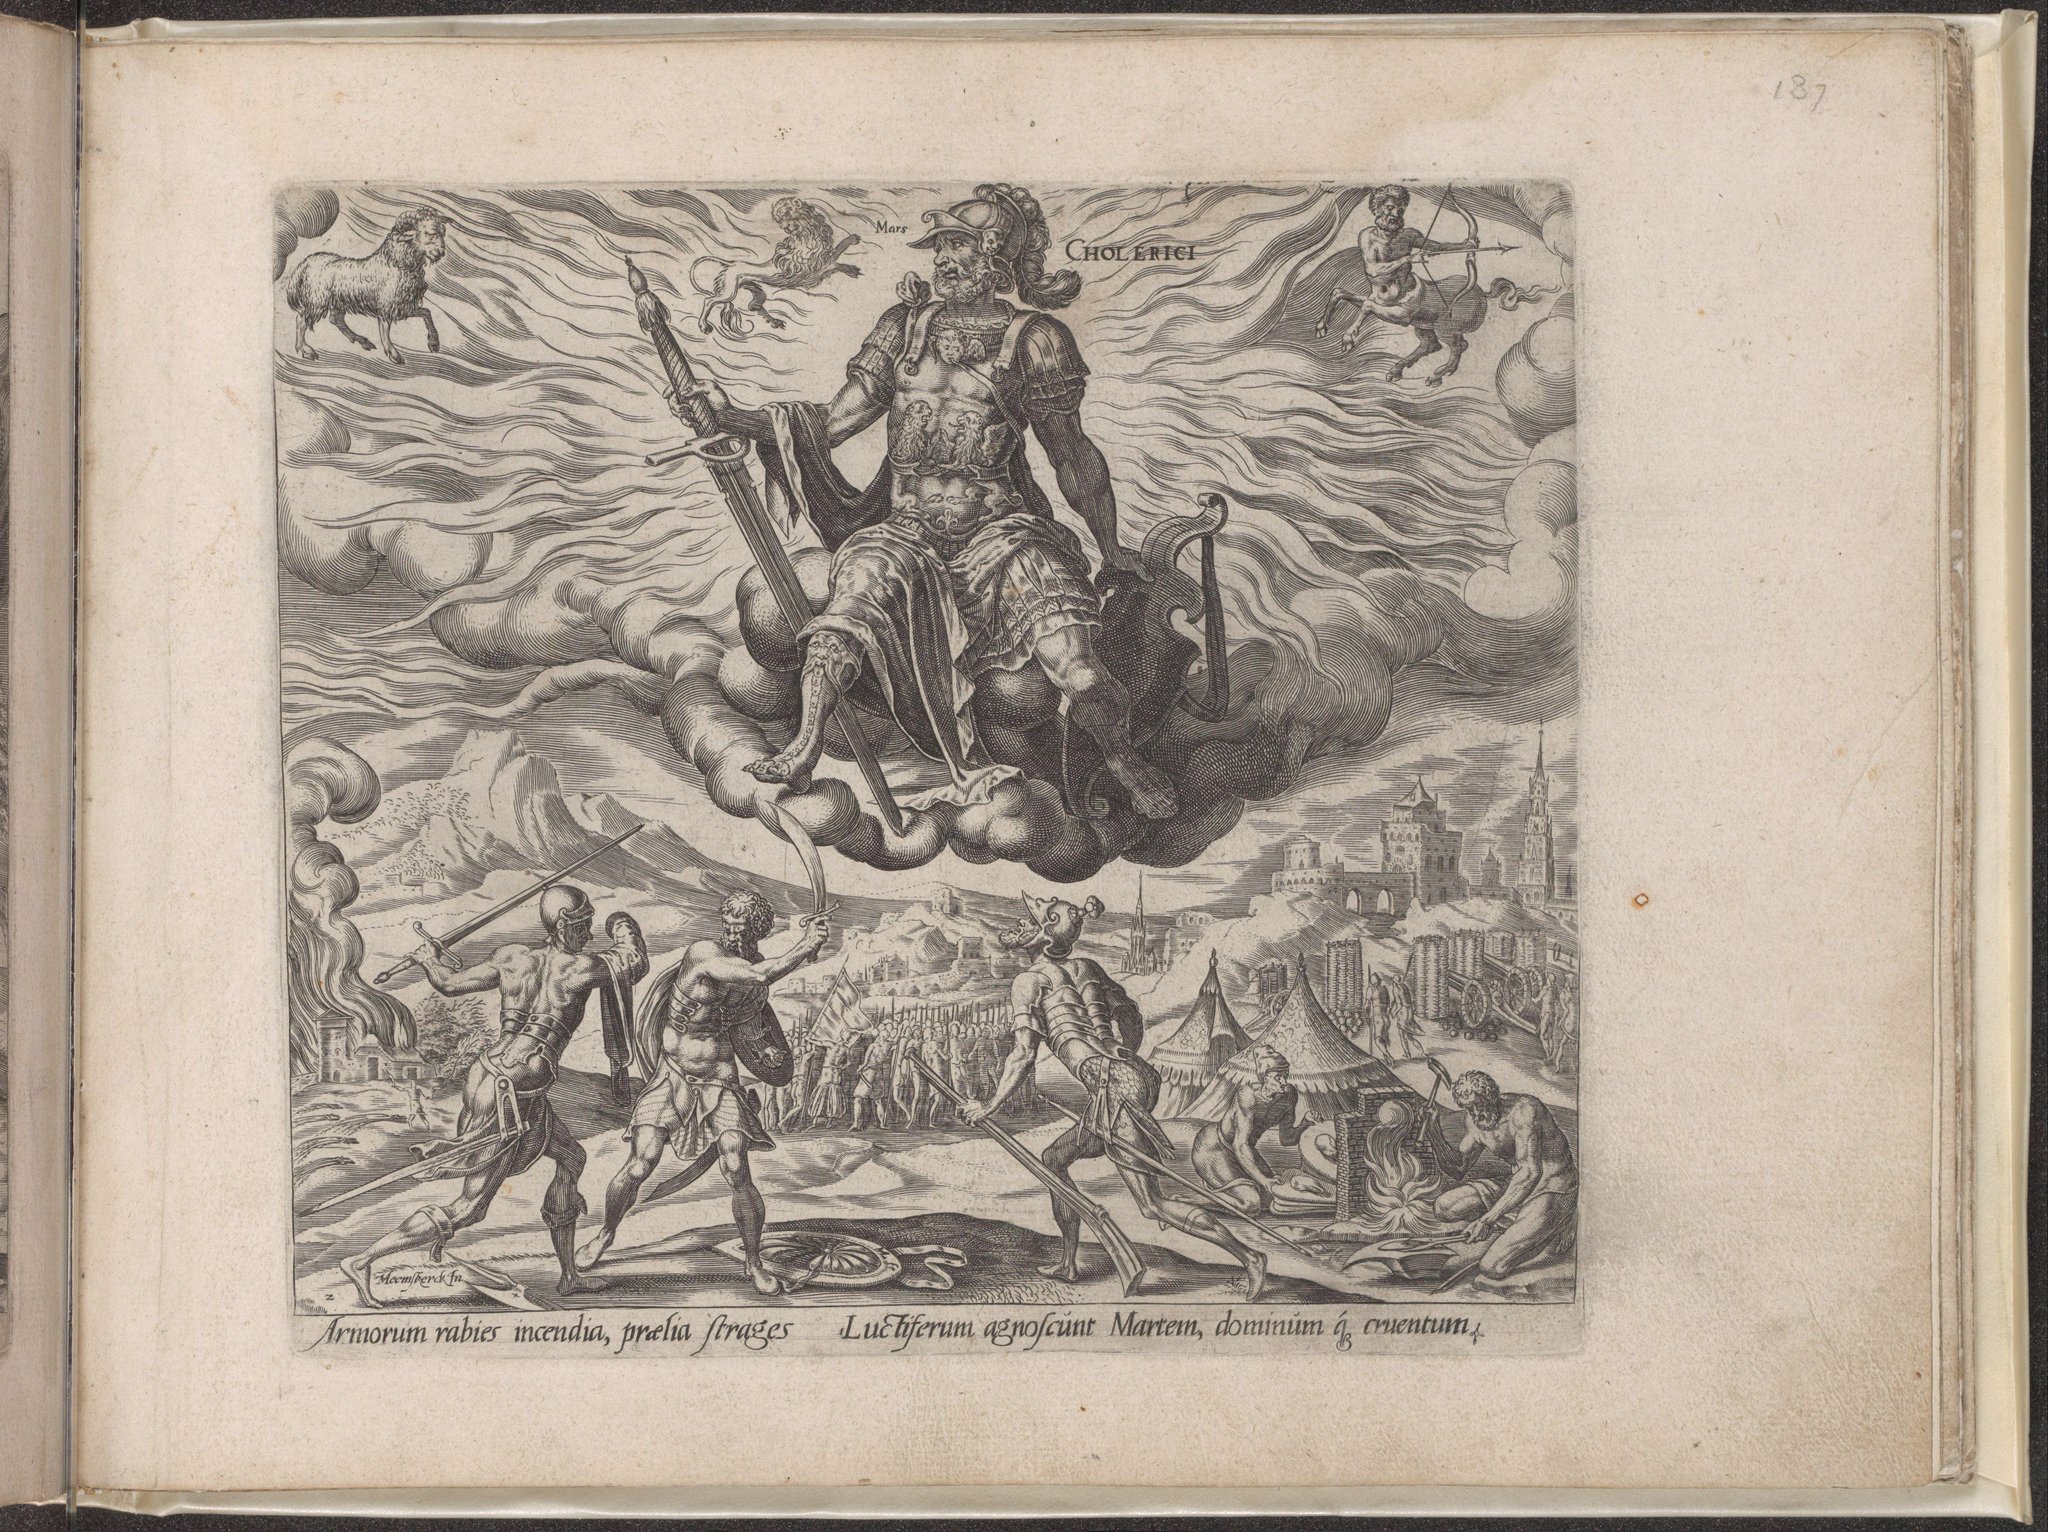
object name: print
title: De vier temperamenten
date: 1566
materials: paper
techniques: engraving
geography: haarlem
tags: war, smith, blacksmith, choleric temperament, mars (planet)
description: Mars, de god van de oorlog, zit in de hemel met zwaard en schild en verbeeldt de gelijknamige planeet. Boven hem staan drie tekens van de zodiak: Ram, Leeuw en boogschutter, die passen bij het element vuur. Onder hen, op aarde, de mensen, die een cholerisch temperament hebben: soldaten voeren oorlog en een smid is aan het werk. Onderaan in de marge een tekst in het Latijn over de cholerici en de bijbehorende planeet. Deze prent maakt deel uit van een album.